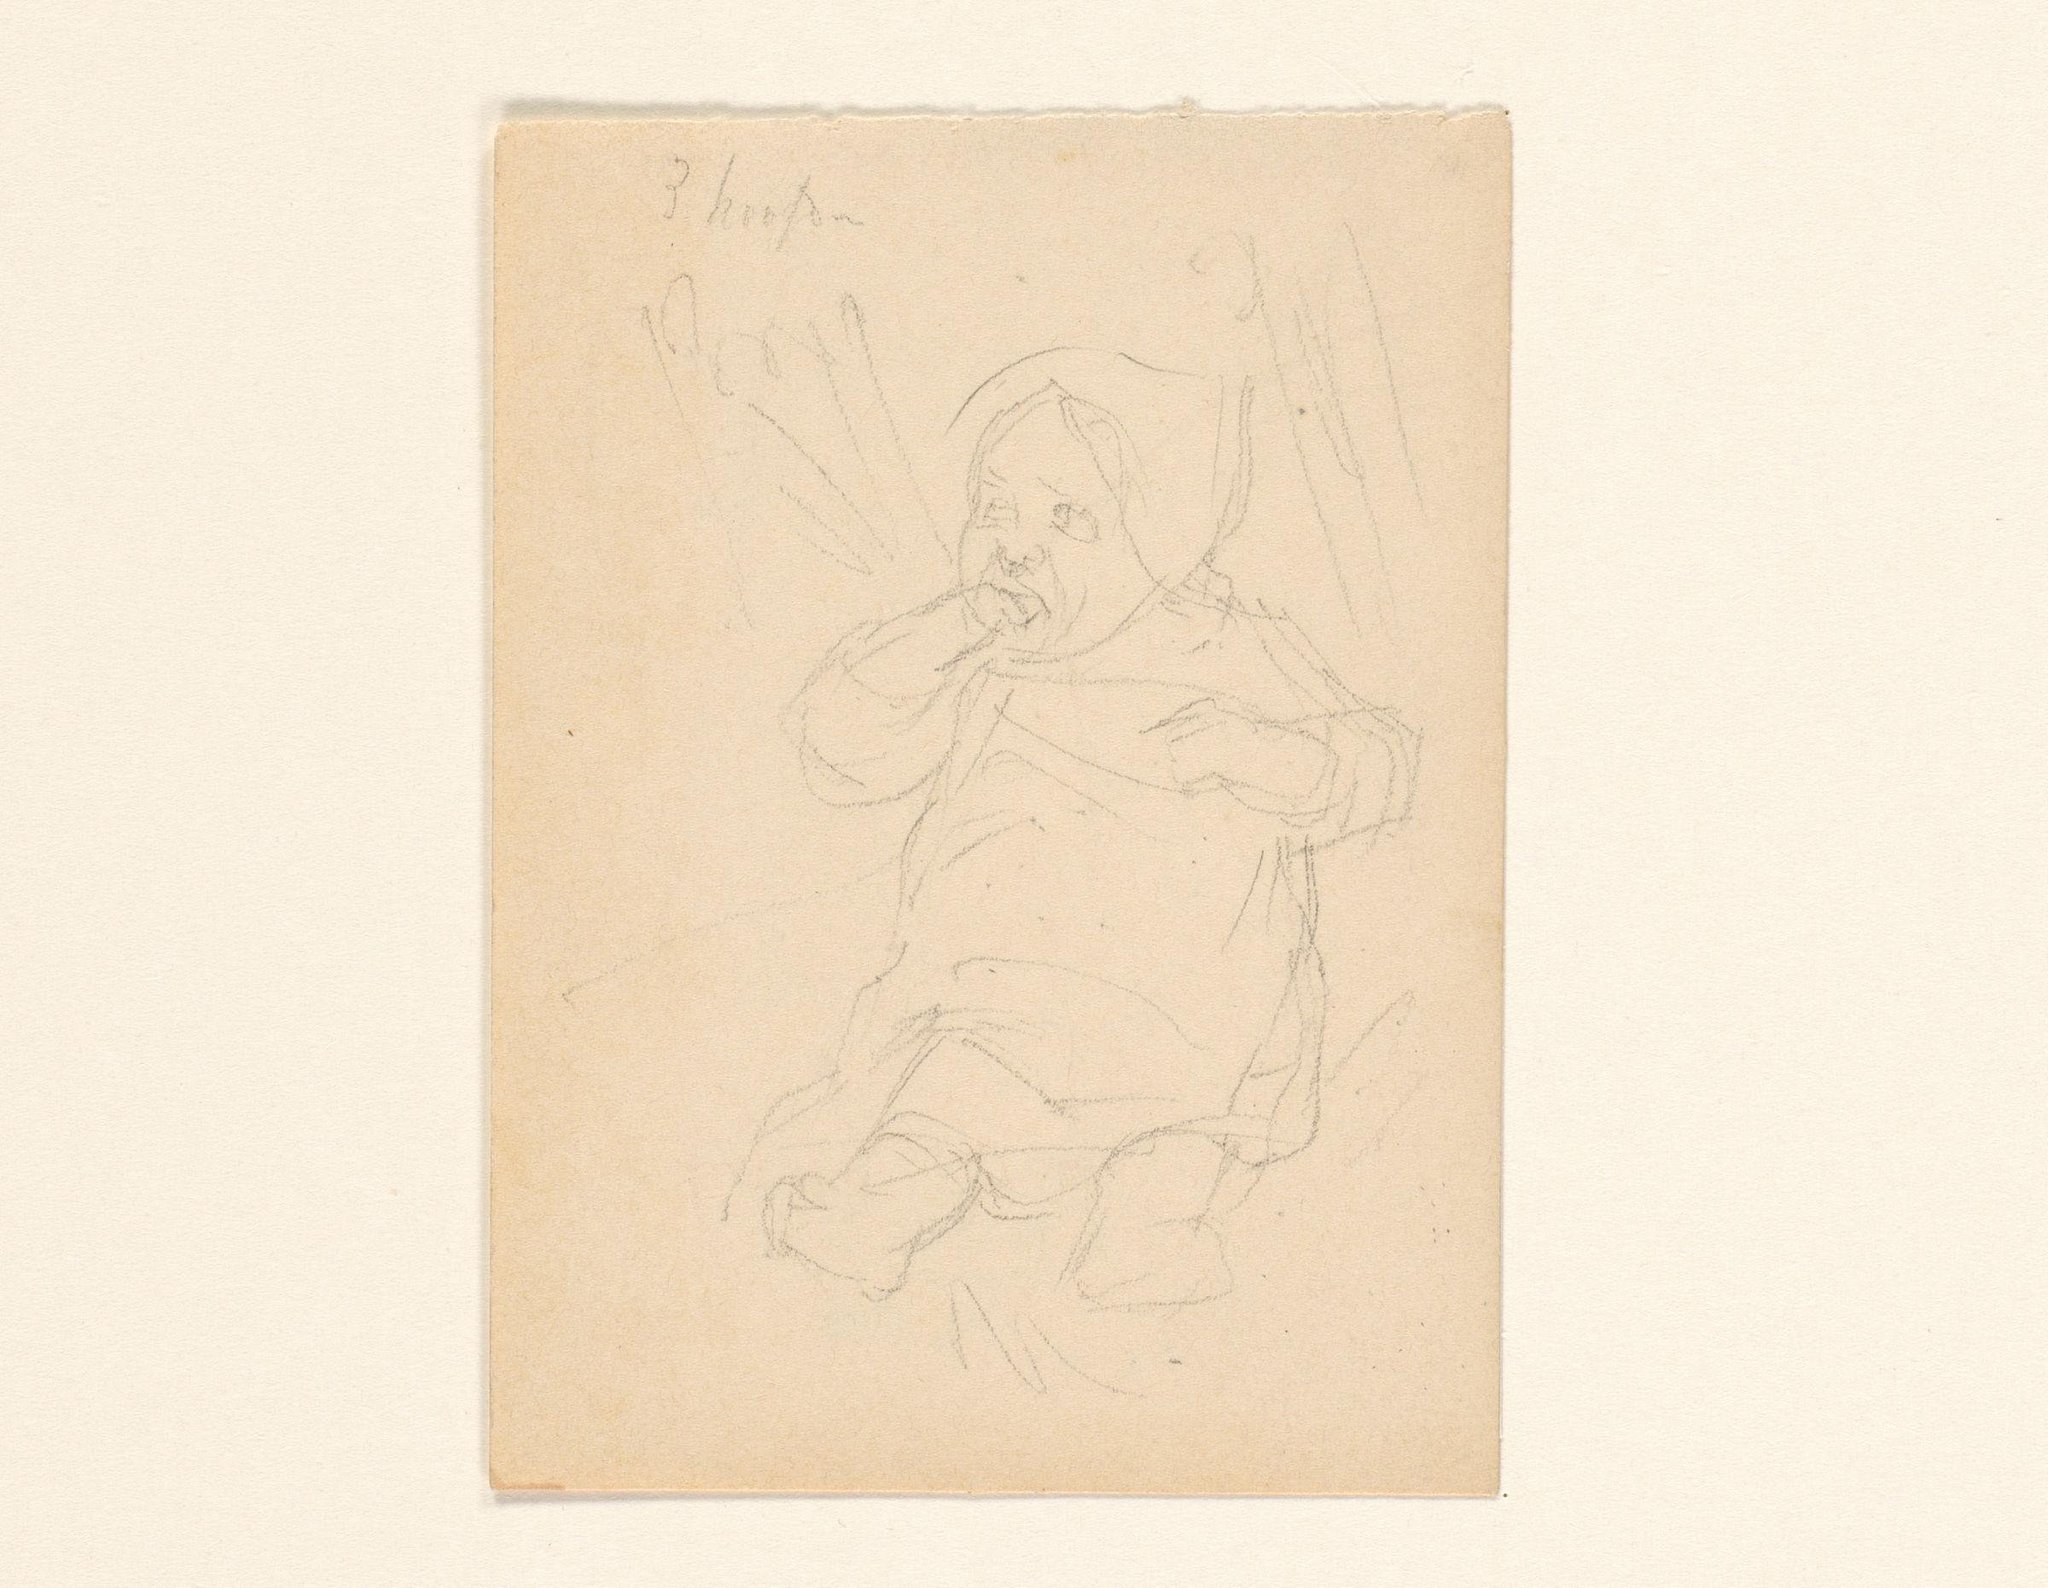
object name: drawing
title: Studie van een baby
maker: august allebé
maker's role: draughtsman, print maker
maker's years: 1838-1927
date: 1848-1927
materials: paper, pencil